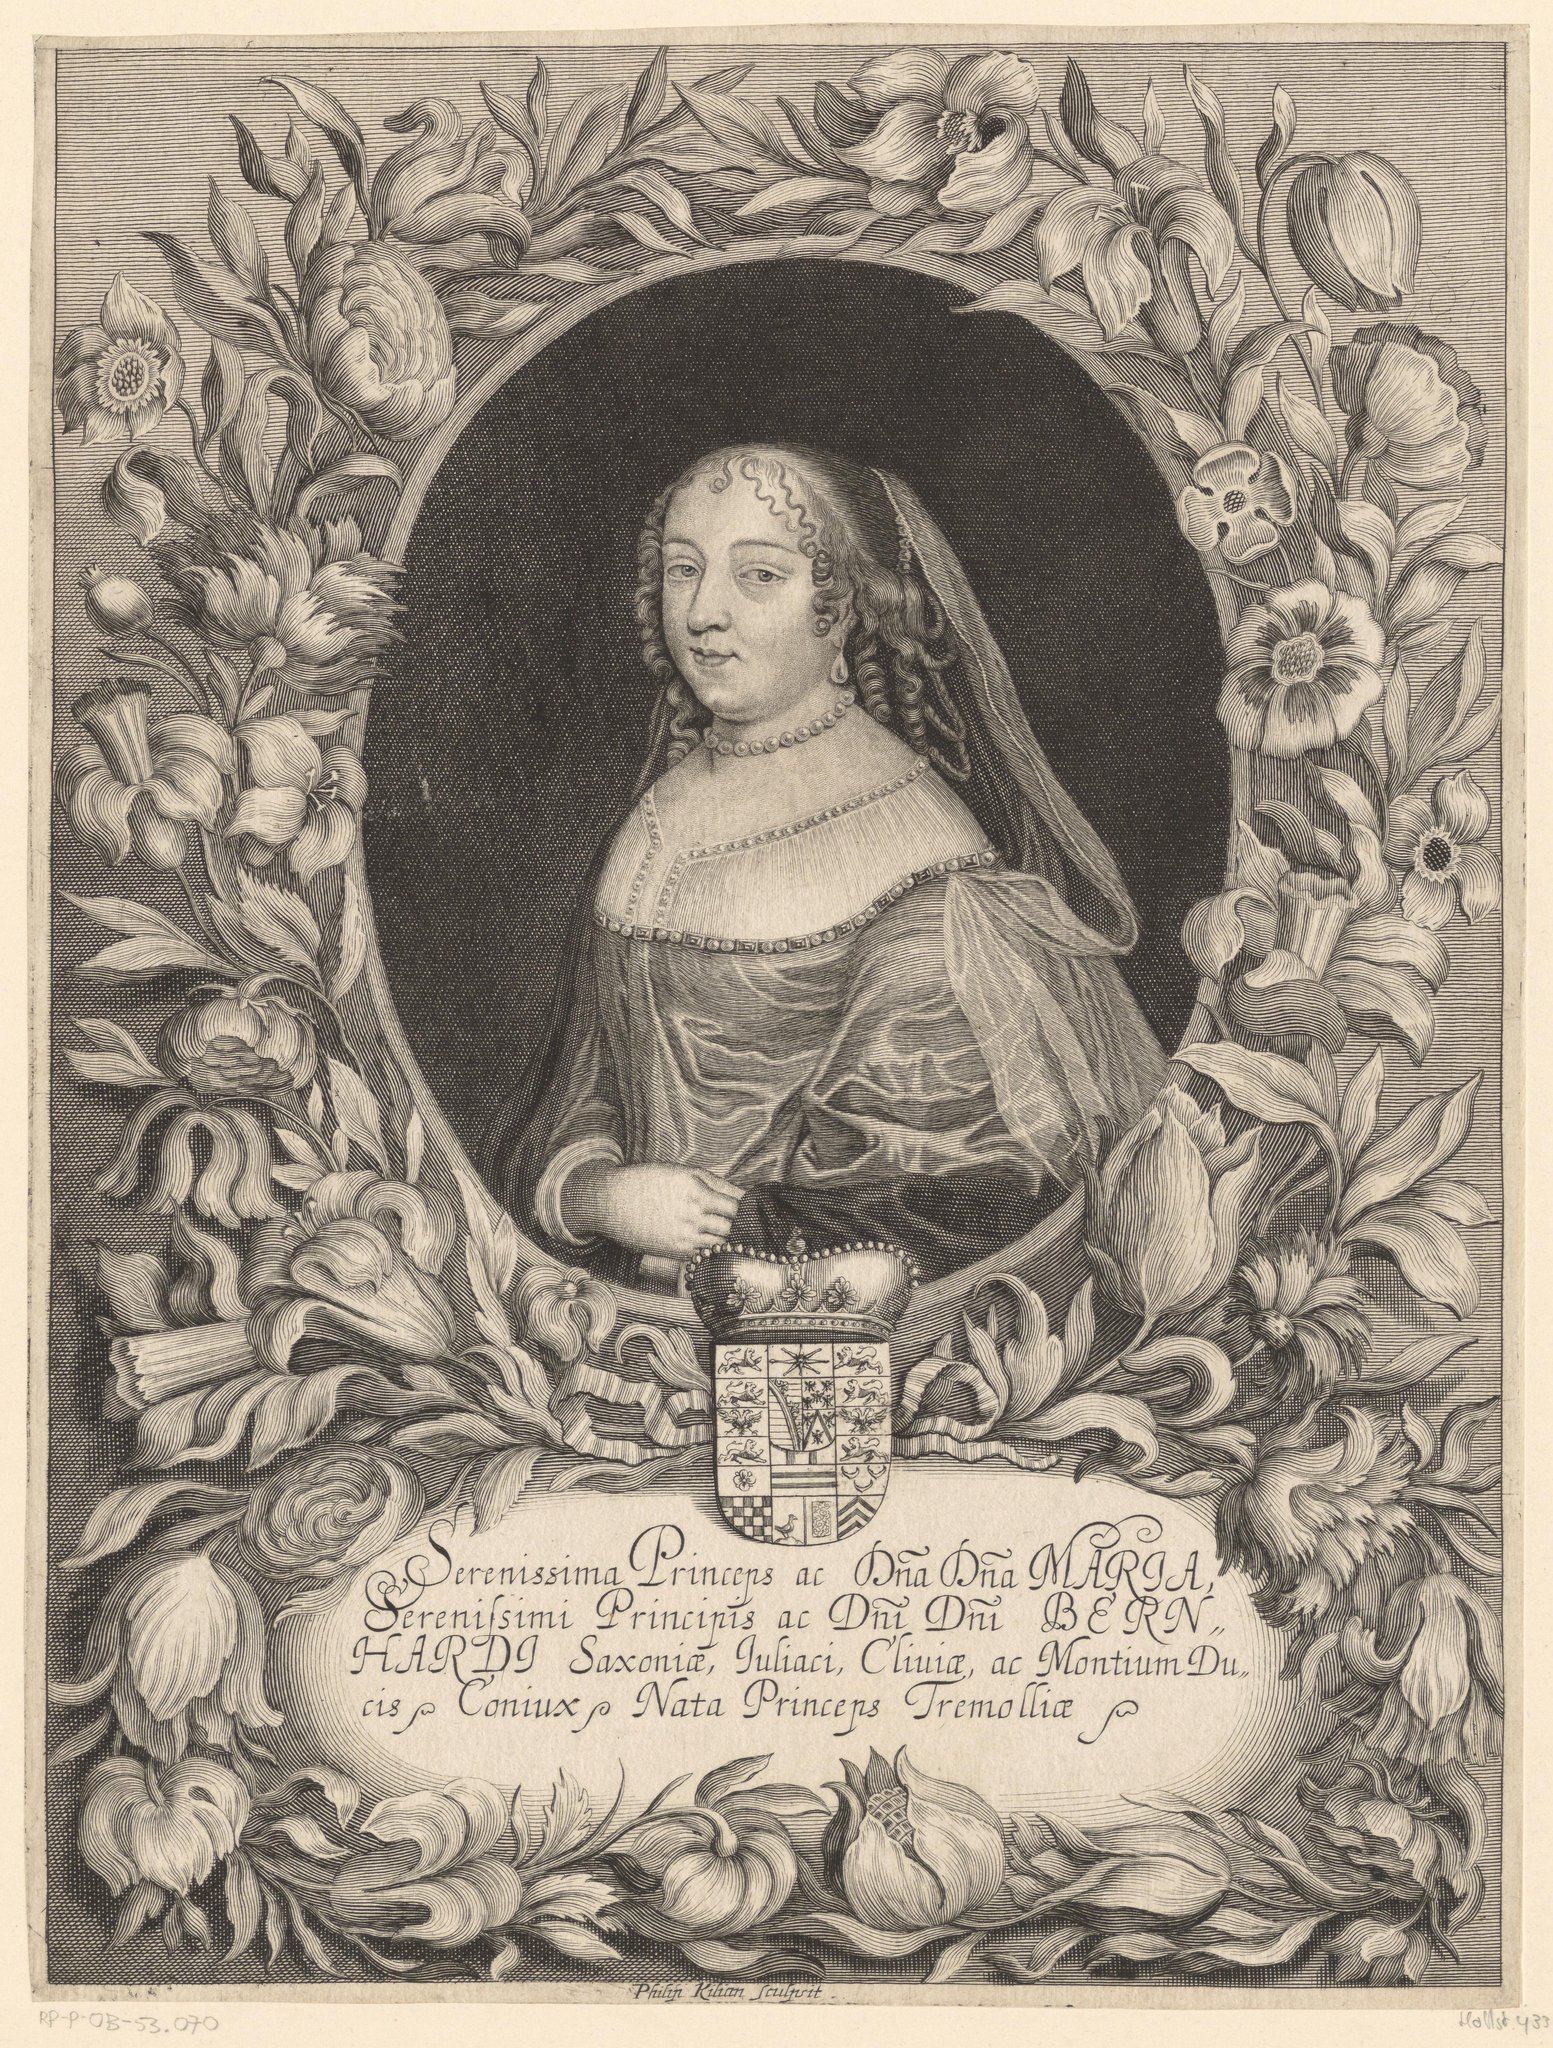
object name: print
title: Portret van Marie Anne de la Trémoille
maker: philipp kilian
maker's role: print maker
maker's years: 1628-1693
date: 1662-1693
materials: paper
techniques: engraving, etching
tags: rome, historical persons, diplomacy, diplomat